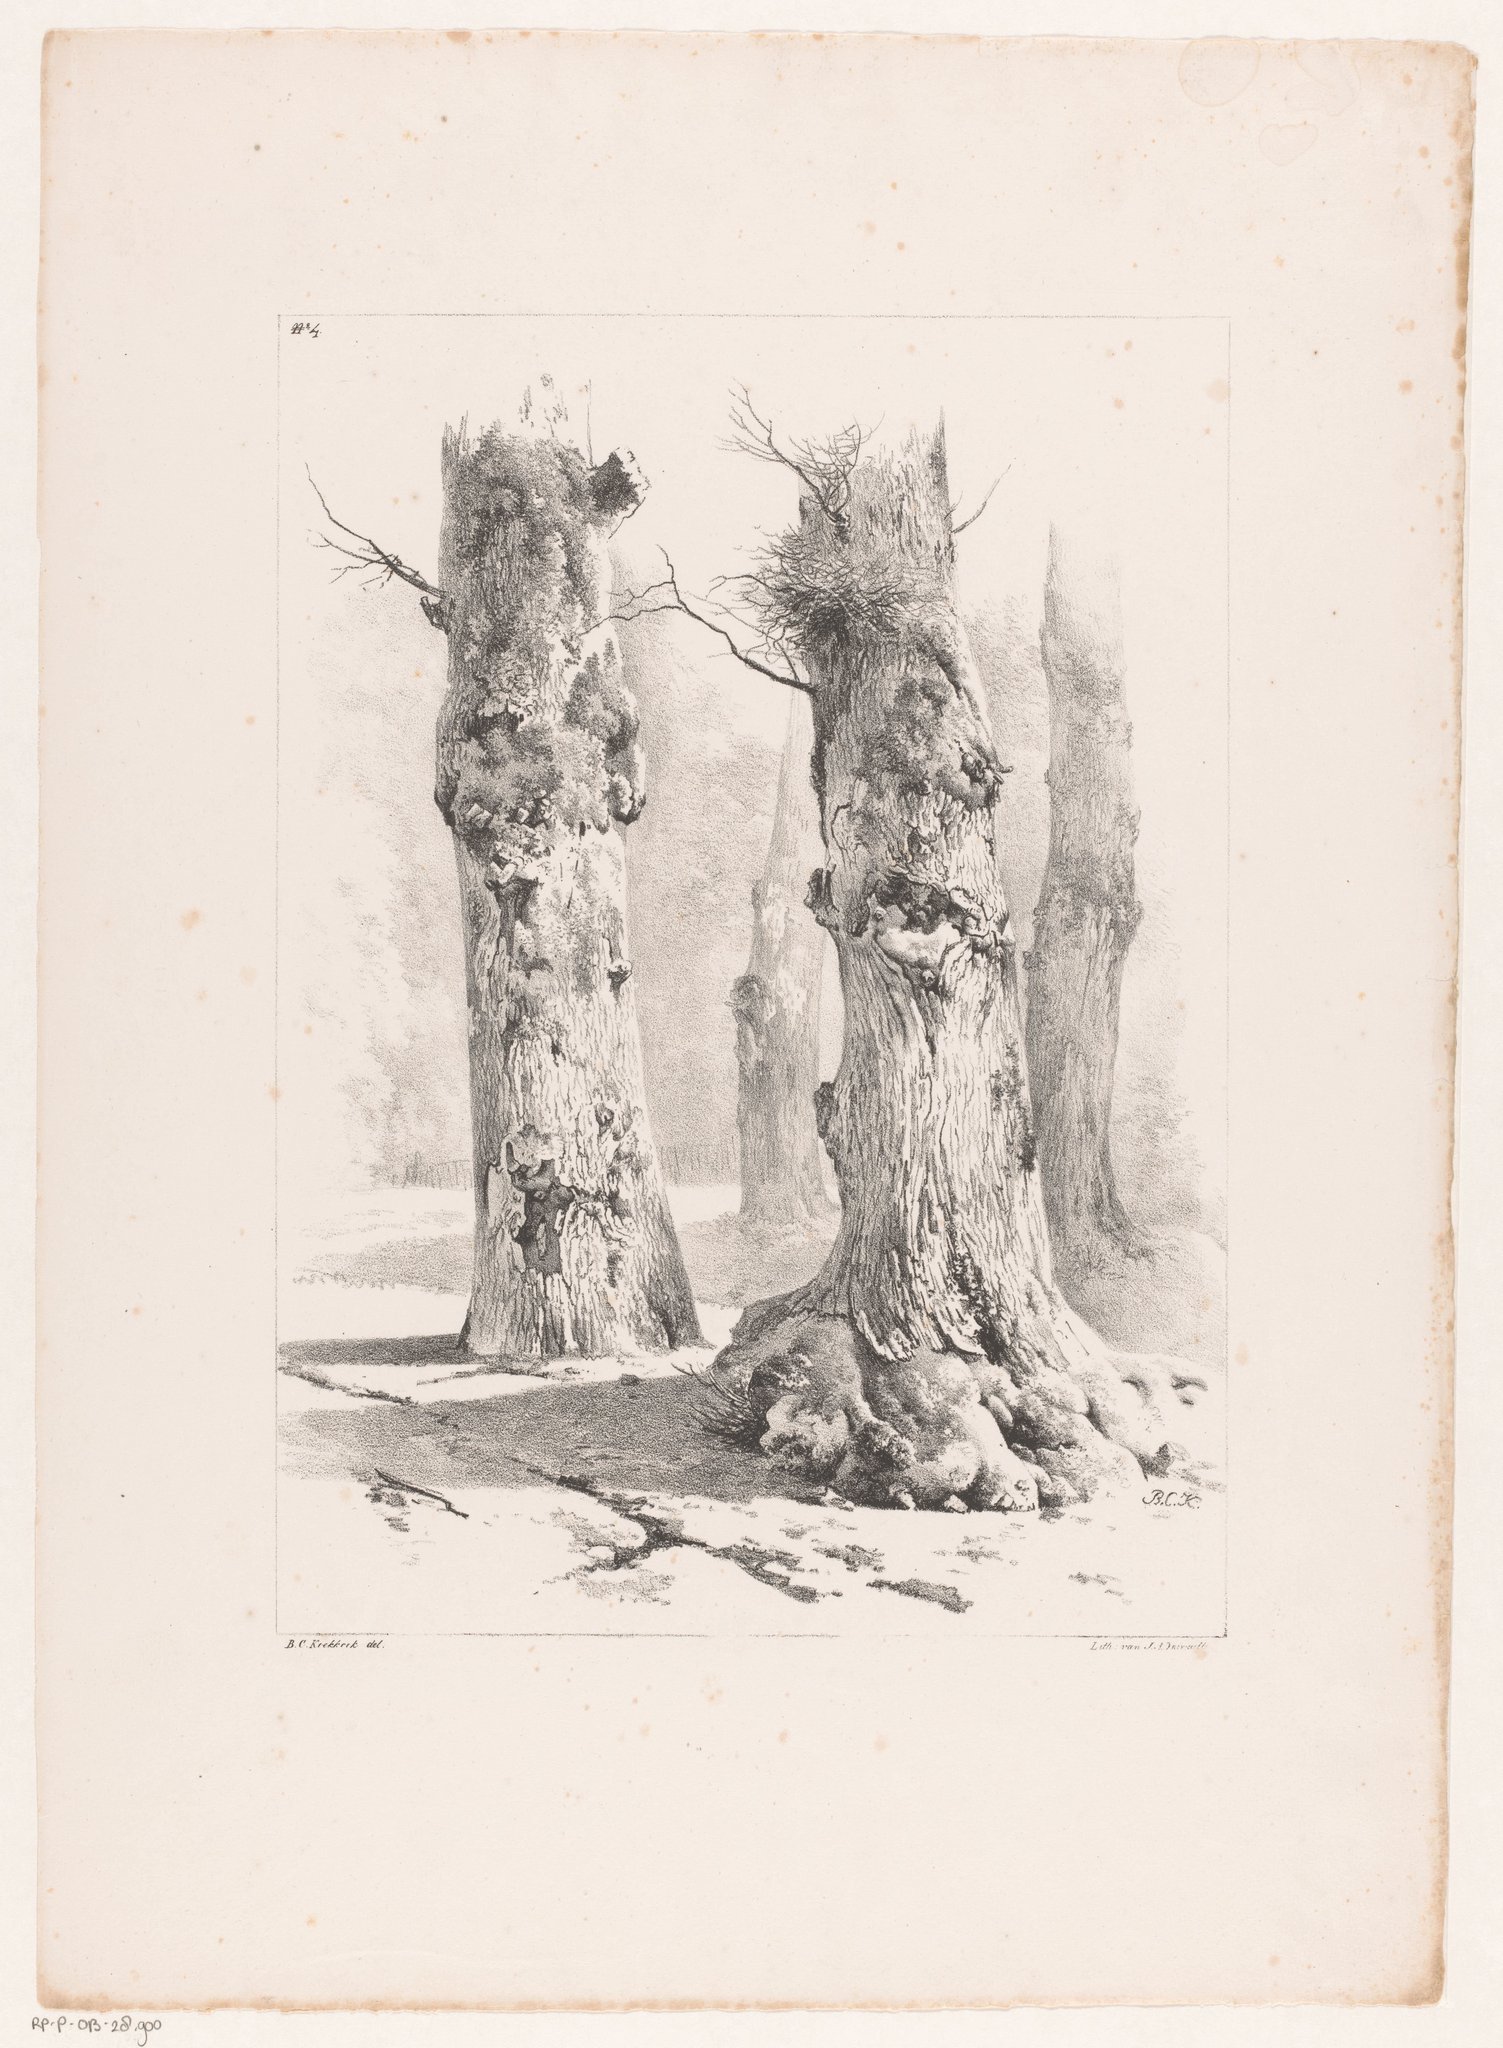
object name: print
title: Vier boomstammen in het bos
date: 1829-1830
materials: paper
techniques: lithograph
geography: amsterdam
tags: forest, wood, groups of trees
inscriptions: collector's mark: Lugt 2228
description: In 1829 en 1830 gaf Koekkoek, samen met Daiwaille, zes cahiers uit met ieder zes prenten getiteld Landschapstudiën. Deze werden gebruikt in het tekenonderwijs. Vijftien jaar later werd deze reeks, in een andere samenstelling nogmaals uitgegeven door Meyer en Comp in Amsterdam. Zie: De Bruyn Kops, 1963 en Nollert, 1997.